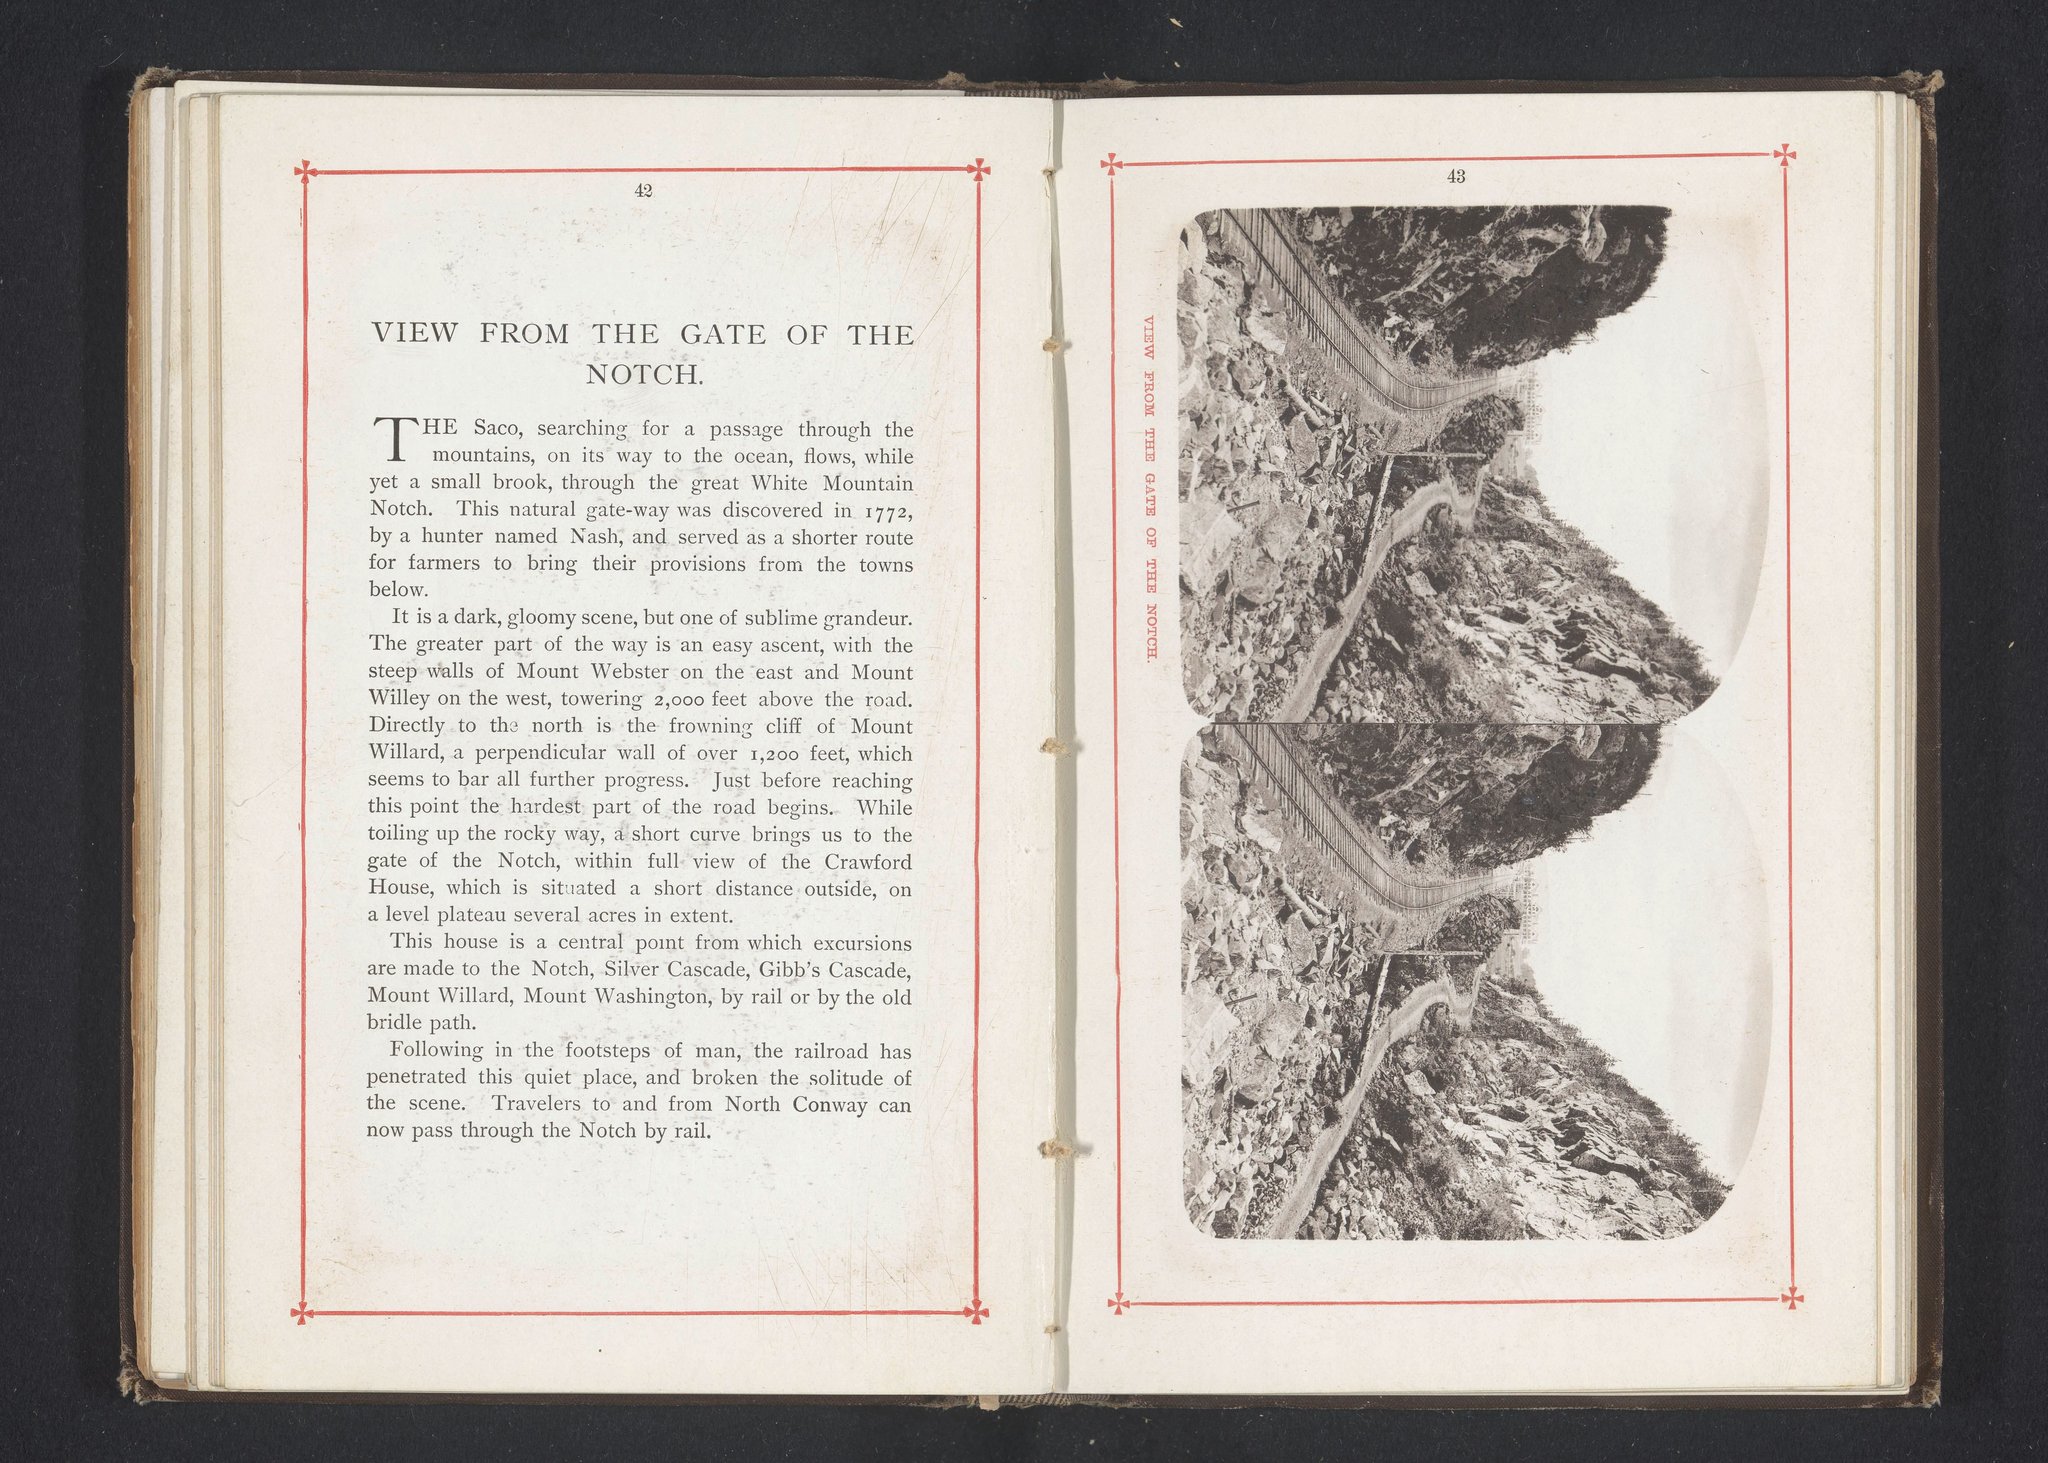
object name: stereograph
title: View from the gate of the Notch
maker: Anonymous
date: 1873-1878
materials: paper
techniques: photograph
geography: franconia notch state park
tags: landscapes, railway, train